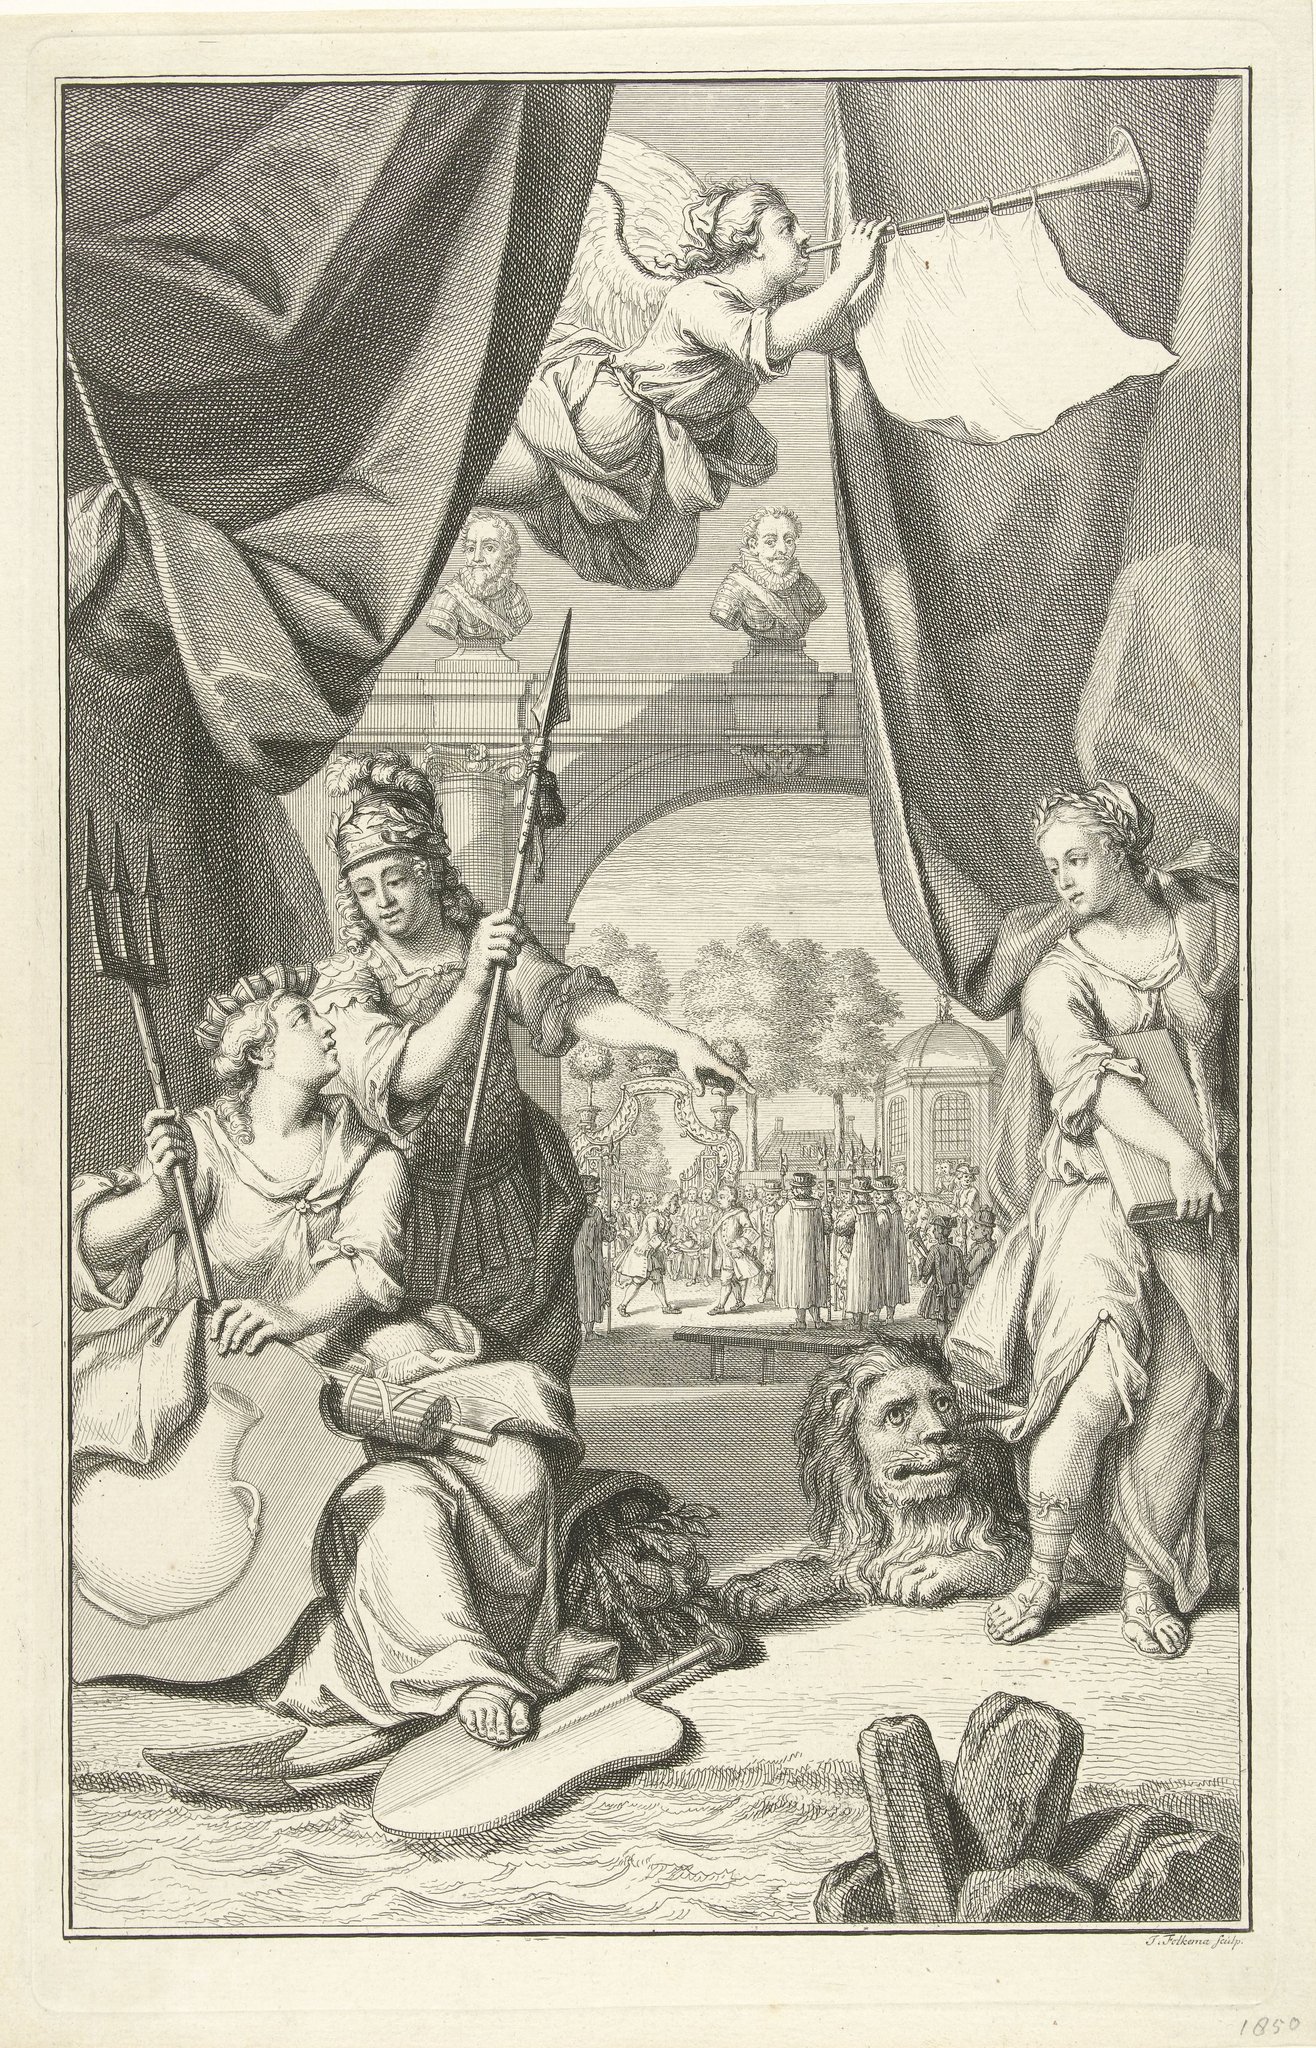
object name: print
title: Allegorische titelplaat met het aanbieden van de sleutels, 1751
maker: jacob folkema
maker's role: draughtsman, print maker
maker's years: 1692-1767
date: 1753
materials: paper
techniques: engraving, etching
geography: northern netherlands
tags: the hague, willem iv (prins van oranje-nassau), surrender of keys, flushing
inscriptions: collector's mark: Lugt 2228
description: Allegorische titelplaat met het aanbieden van de sleutels van de stad aan de stadhouder. Op de voorgrond de stadsmaagd van Vlissingen met Mars, rechts de Geschiedenis, in de lucht de Faam. Onderdeel van de illustraties van de inhuldiging van Willem IV als erfheer van Vlissingen op 5 juni 1751.